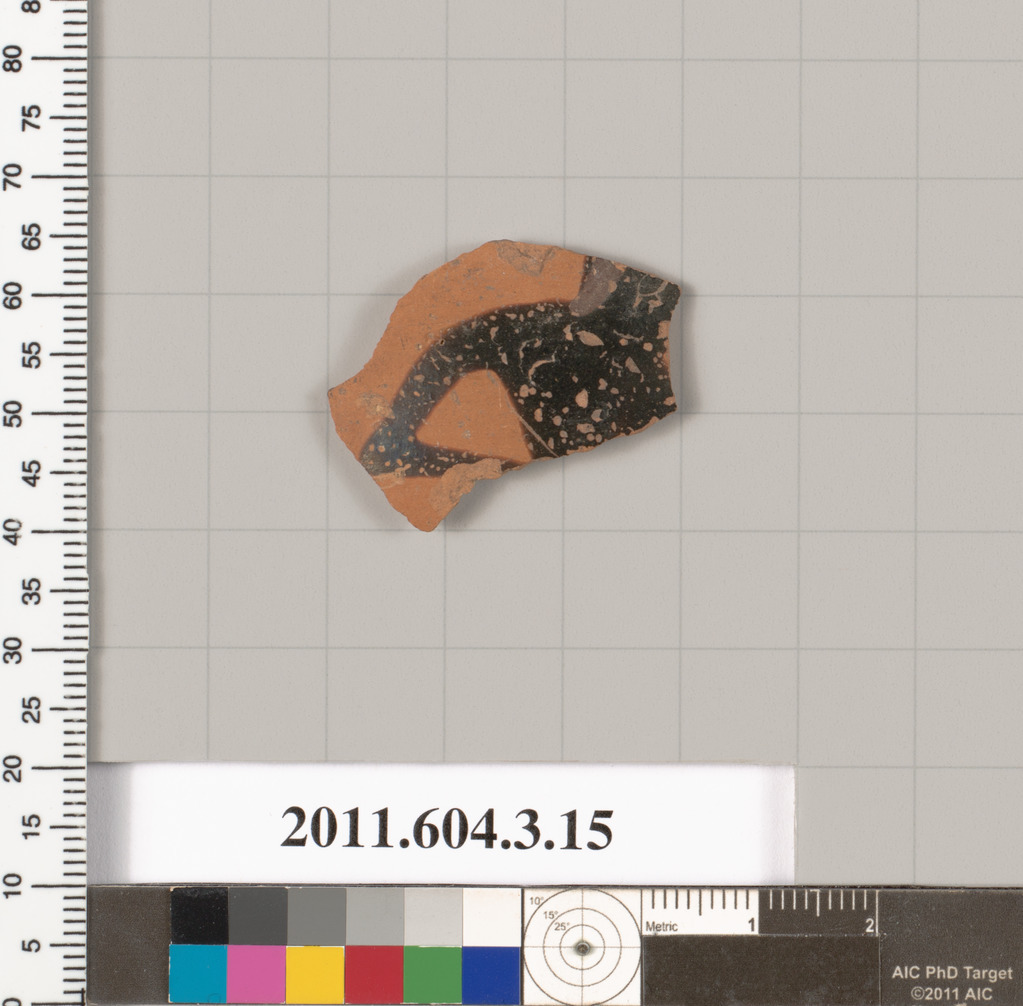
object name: undetermined shape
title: Terracotta fragment of an undetermined shape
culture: greek, attic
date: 600-501 BCE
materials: terracotta